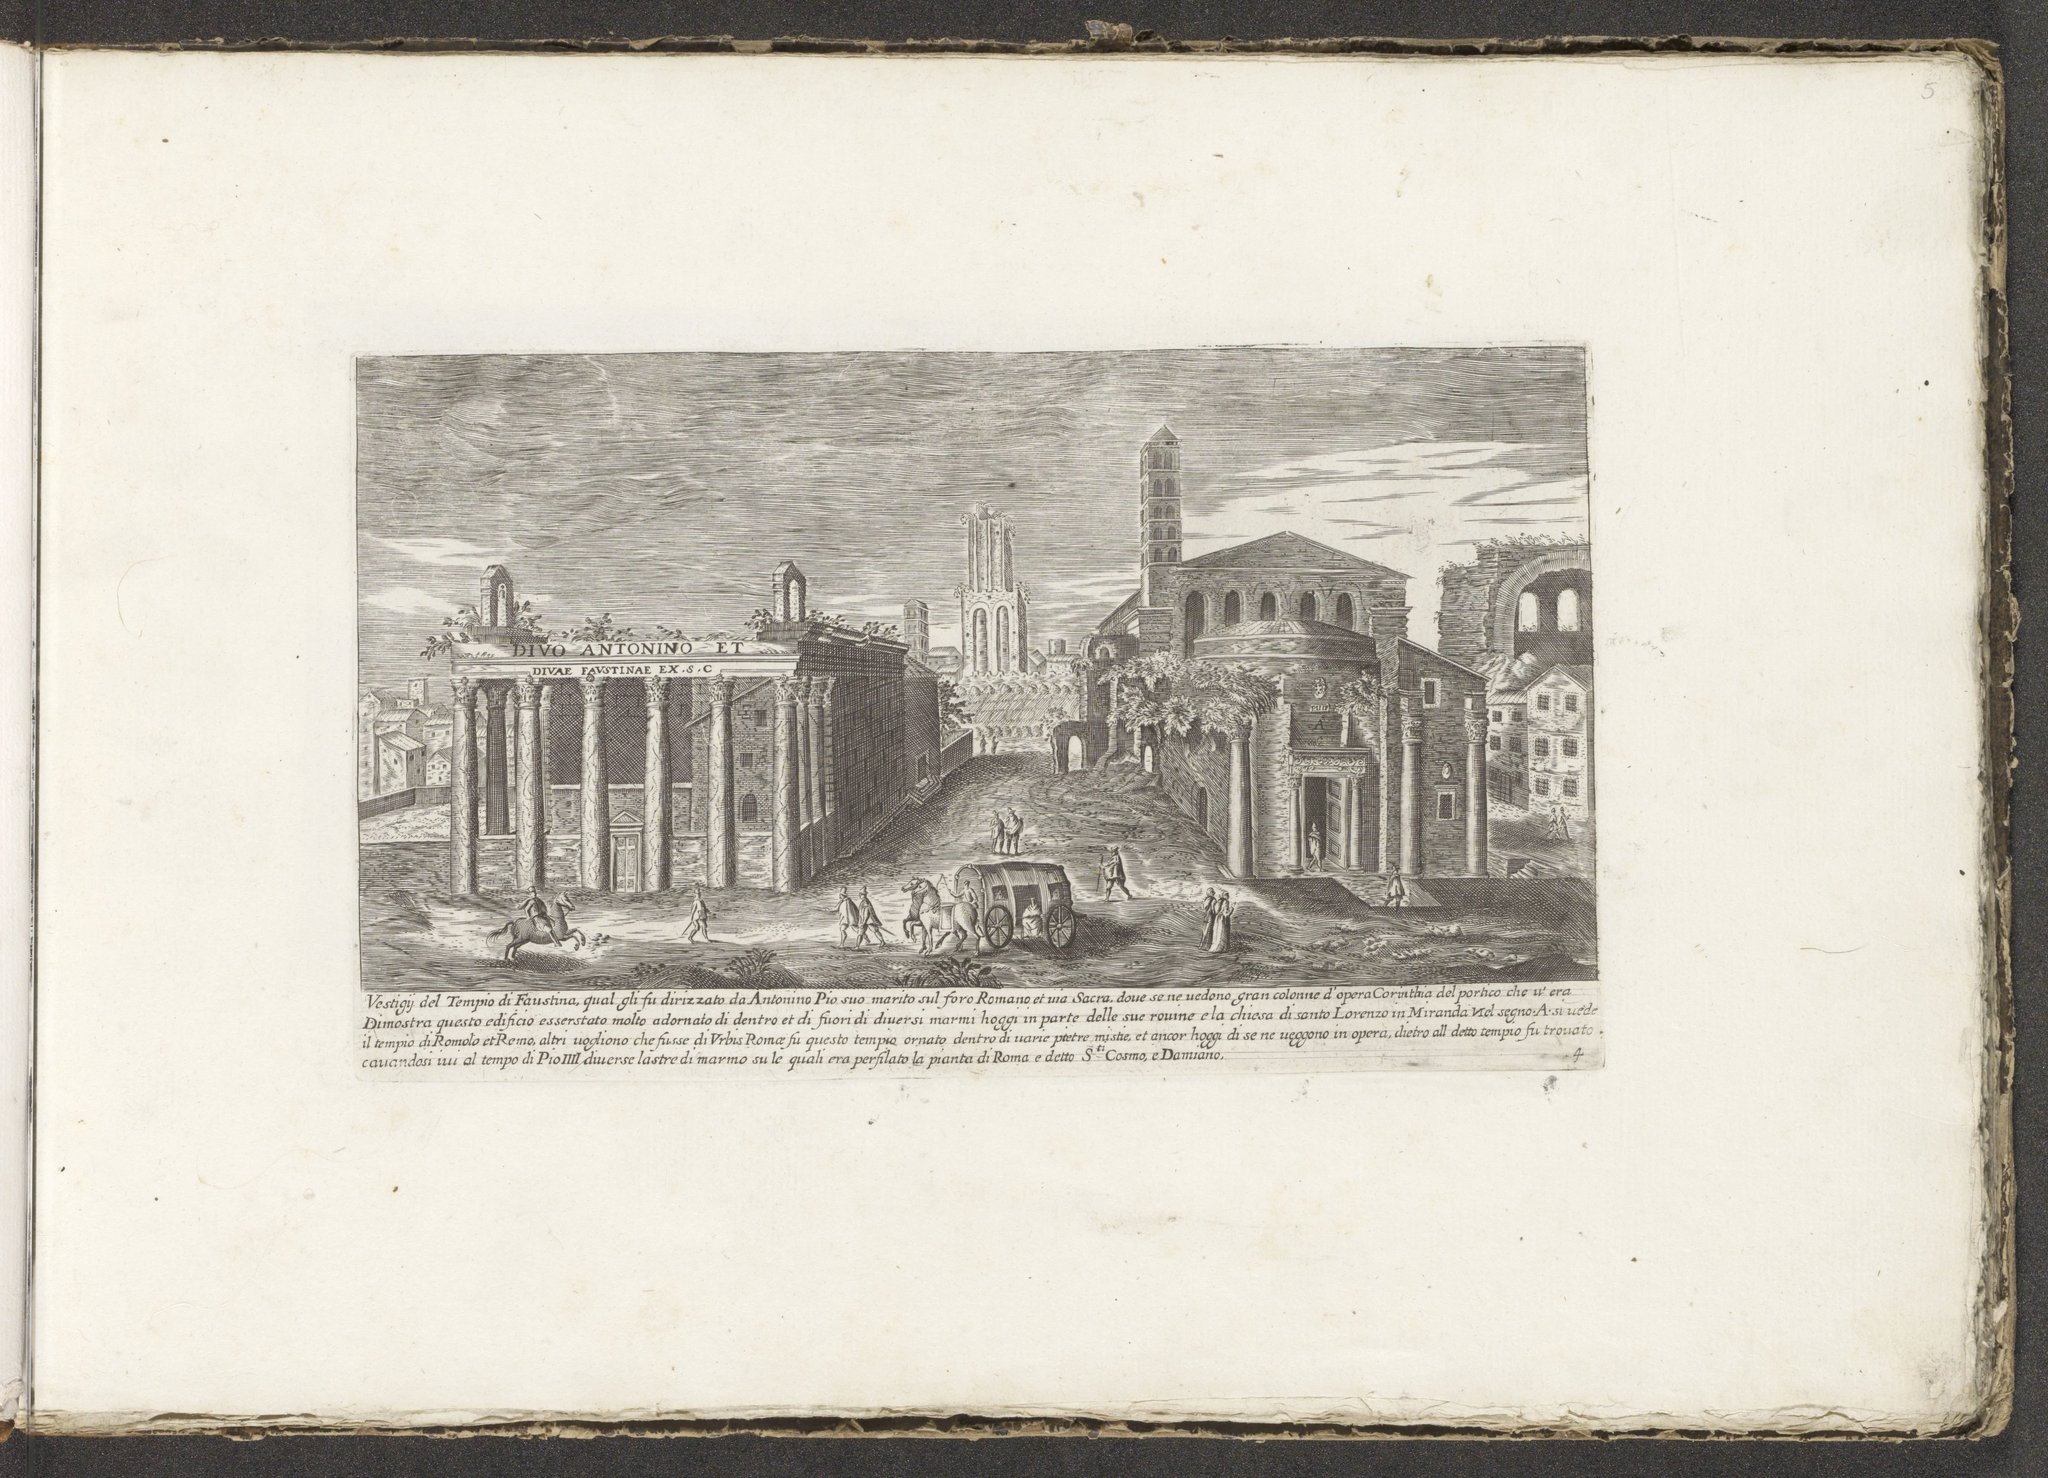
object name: print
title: Tempel van Antoninus Pius en Faustina en de Tempel van Romulus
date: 1680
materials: paper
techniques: engraving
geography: rome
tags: tempel van romulus, torre dei conti, forum romanum, tempel van antoninus en faustina, basilica dei santi cosma e damiano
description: Aanzicht van het Forum Romanum met links de Tempel van Antoninus Pius en Faustina en rechts de Tempel van Romulus, onderdeel van de kerk van de heiligen Cosmas en Daminanus. Op de achtergrond de Torre dei Conti. Op de voorgrond figuren en een rijtuig met twee paarden. In de ondermarge vier regels tekst in het Italiaans. De prent maakt deel uit van een album.